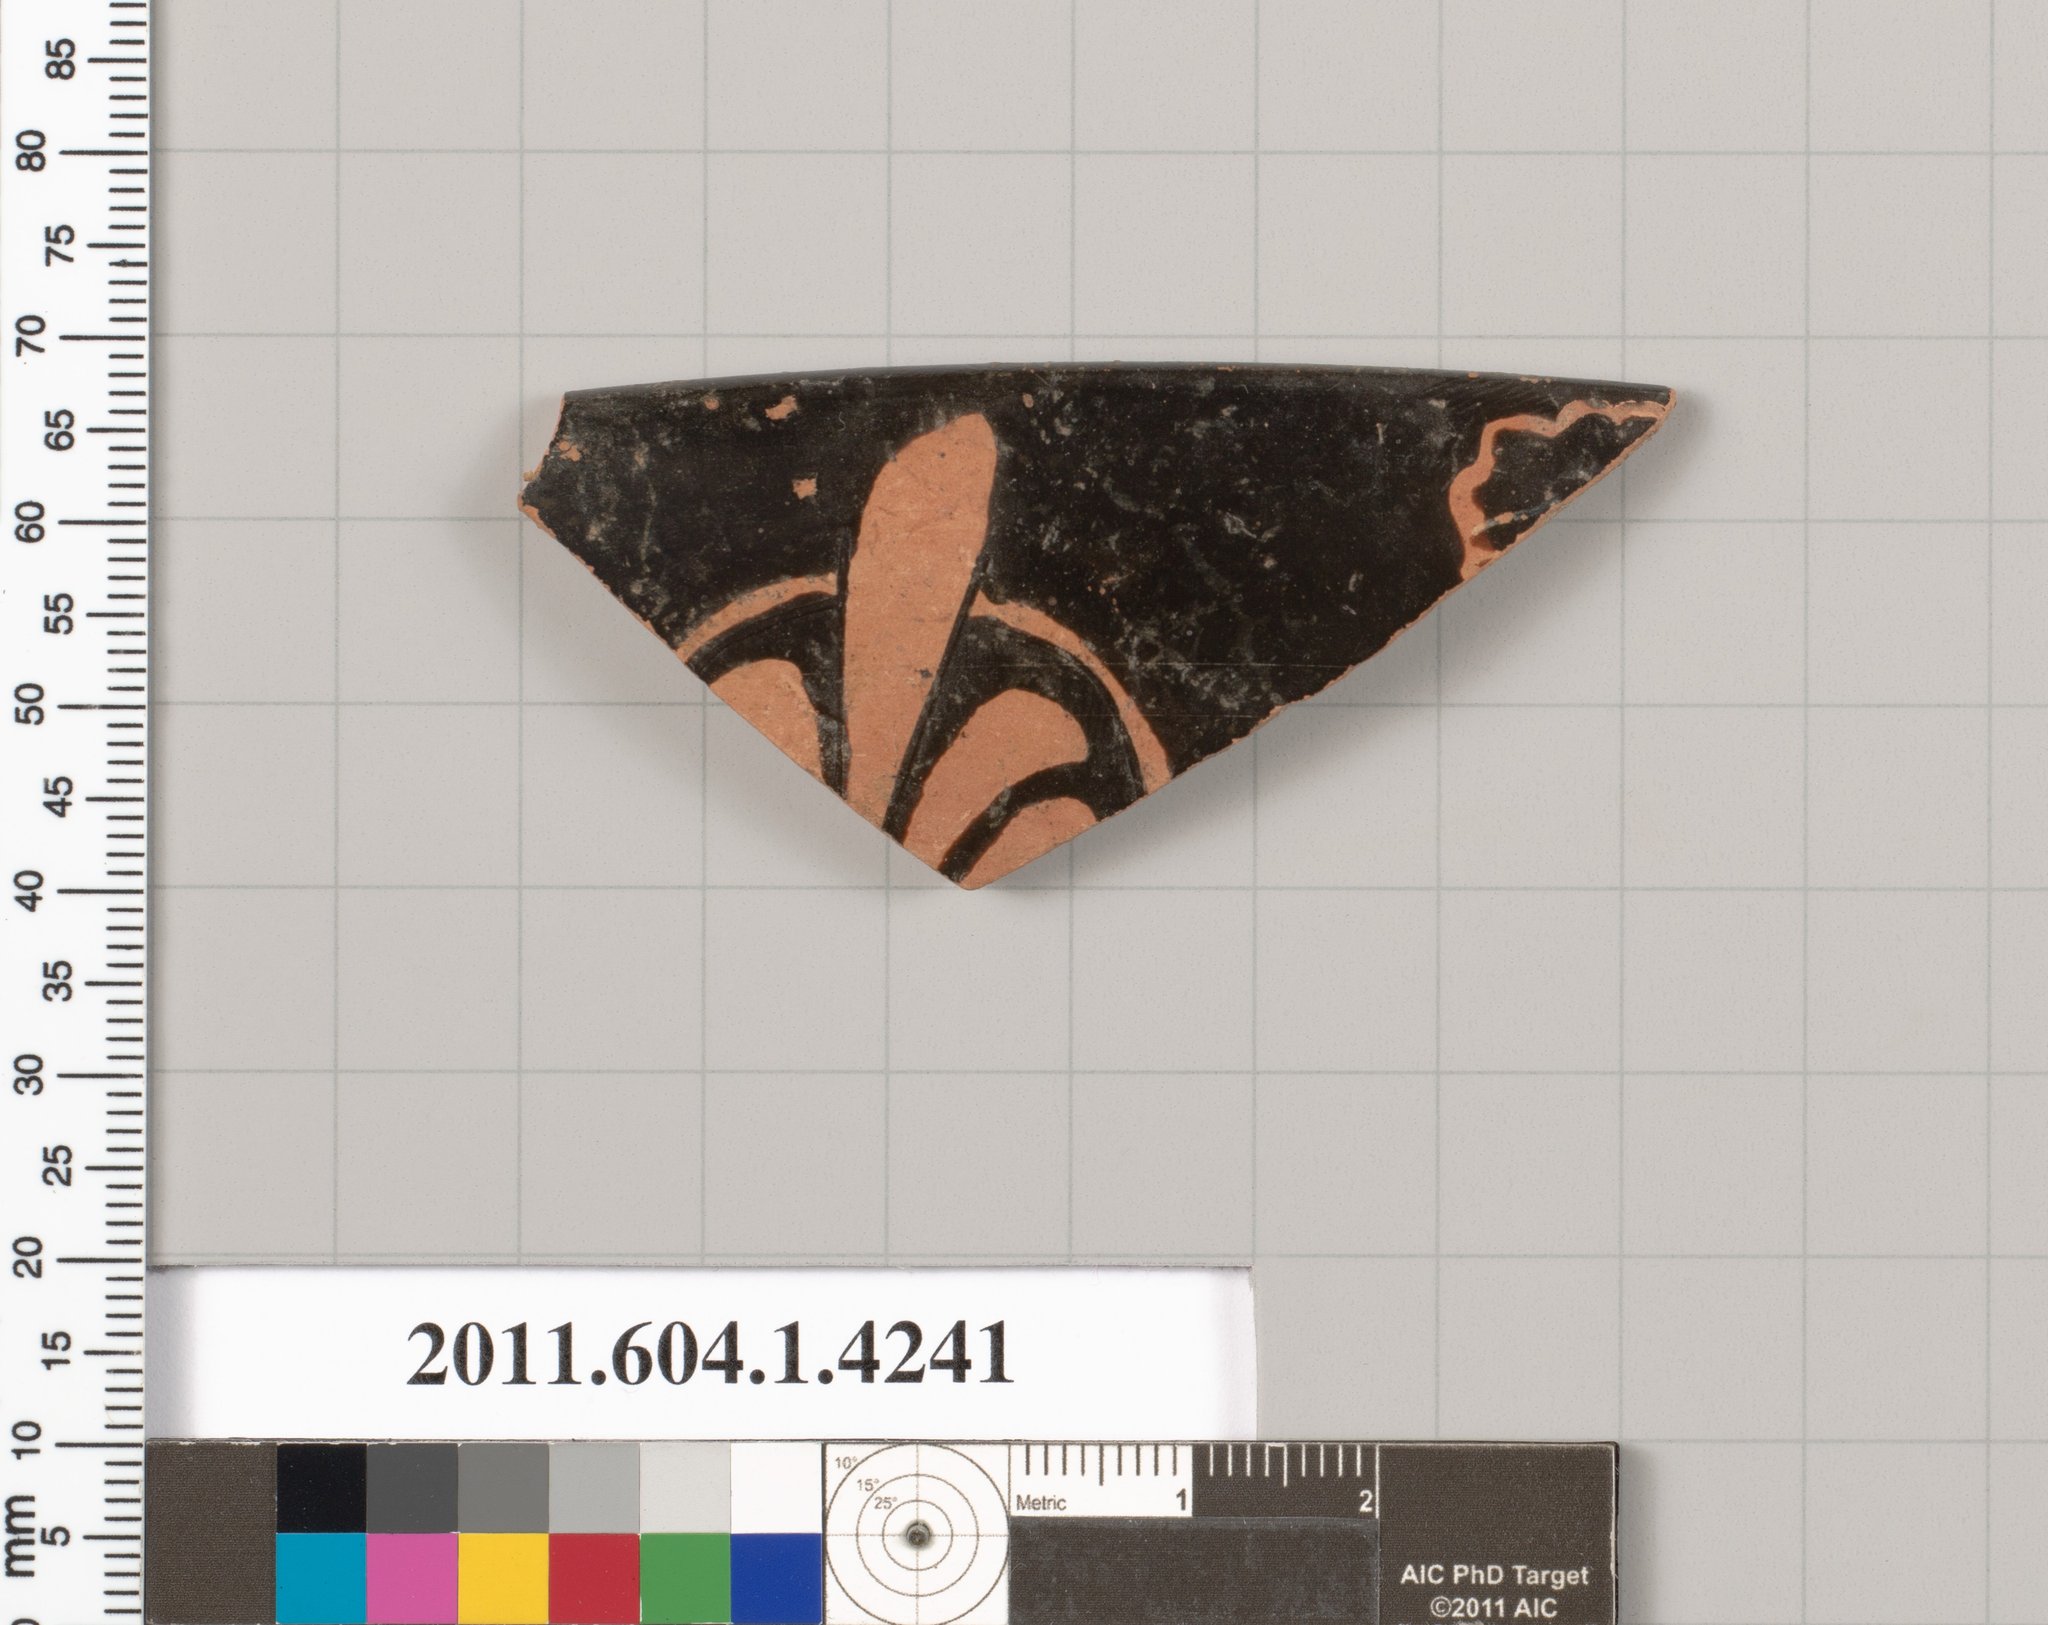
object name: kylix fragment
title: Terracotta rim fragment of a kylix (drinking cup)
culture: greek, attic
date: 467-435 BCE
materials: terracotta